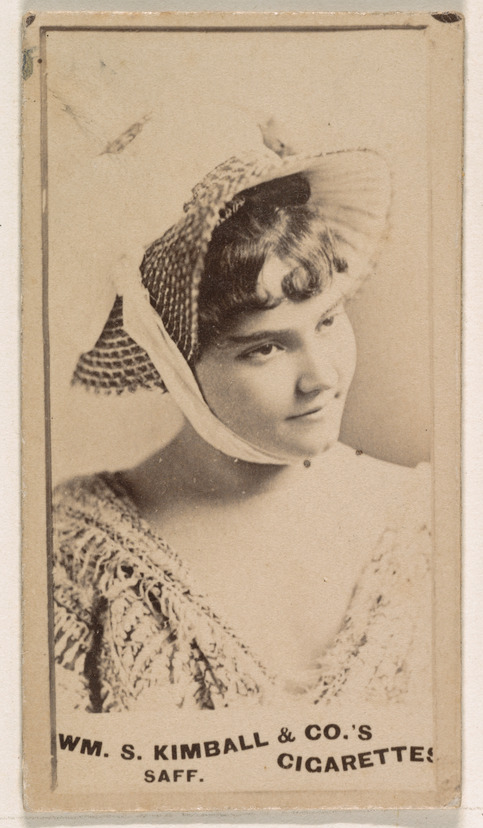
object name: photograph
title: Miss Saff, from the Actresses series (N203) issued by Wm. S. Kimball & Co.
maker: william s. kimball & company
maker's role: publisher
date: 1889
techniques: color lithograph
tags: portraits,women,actresses